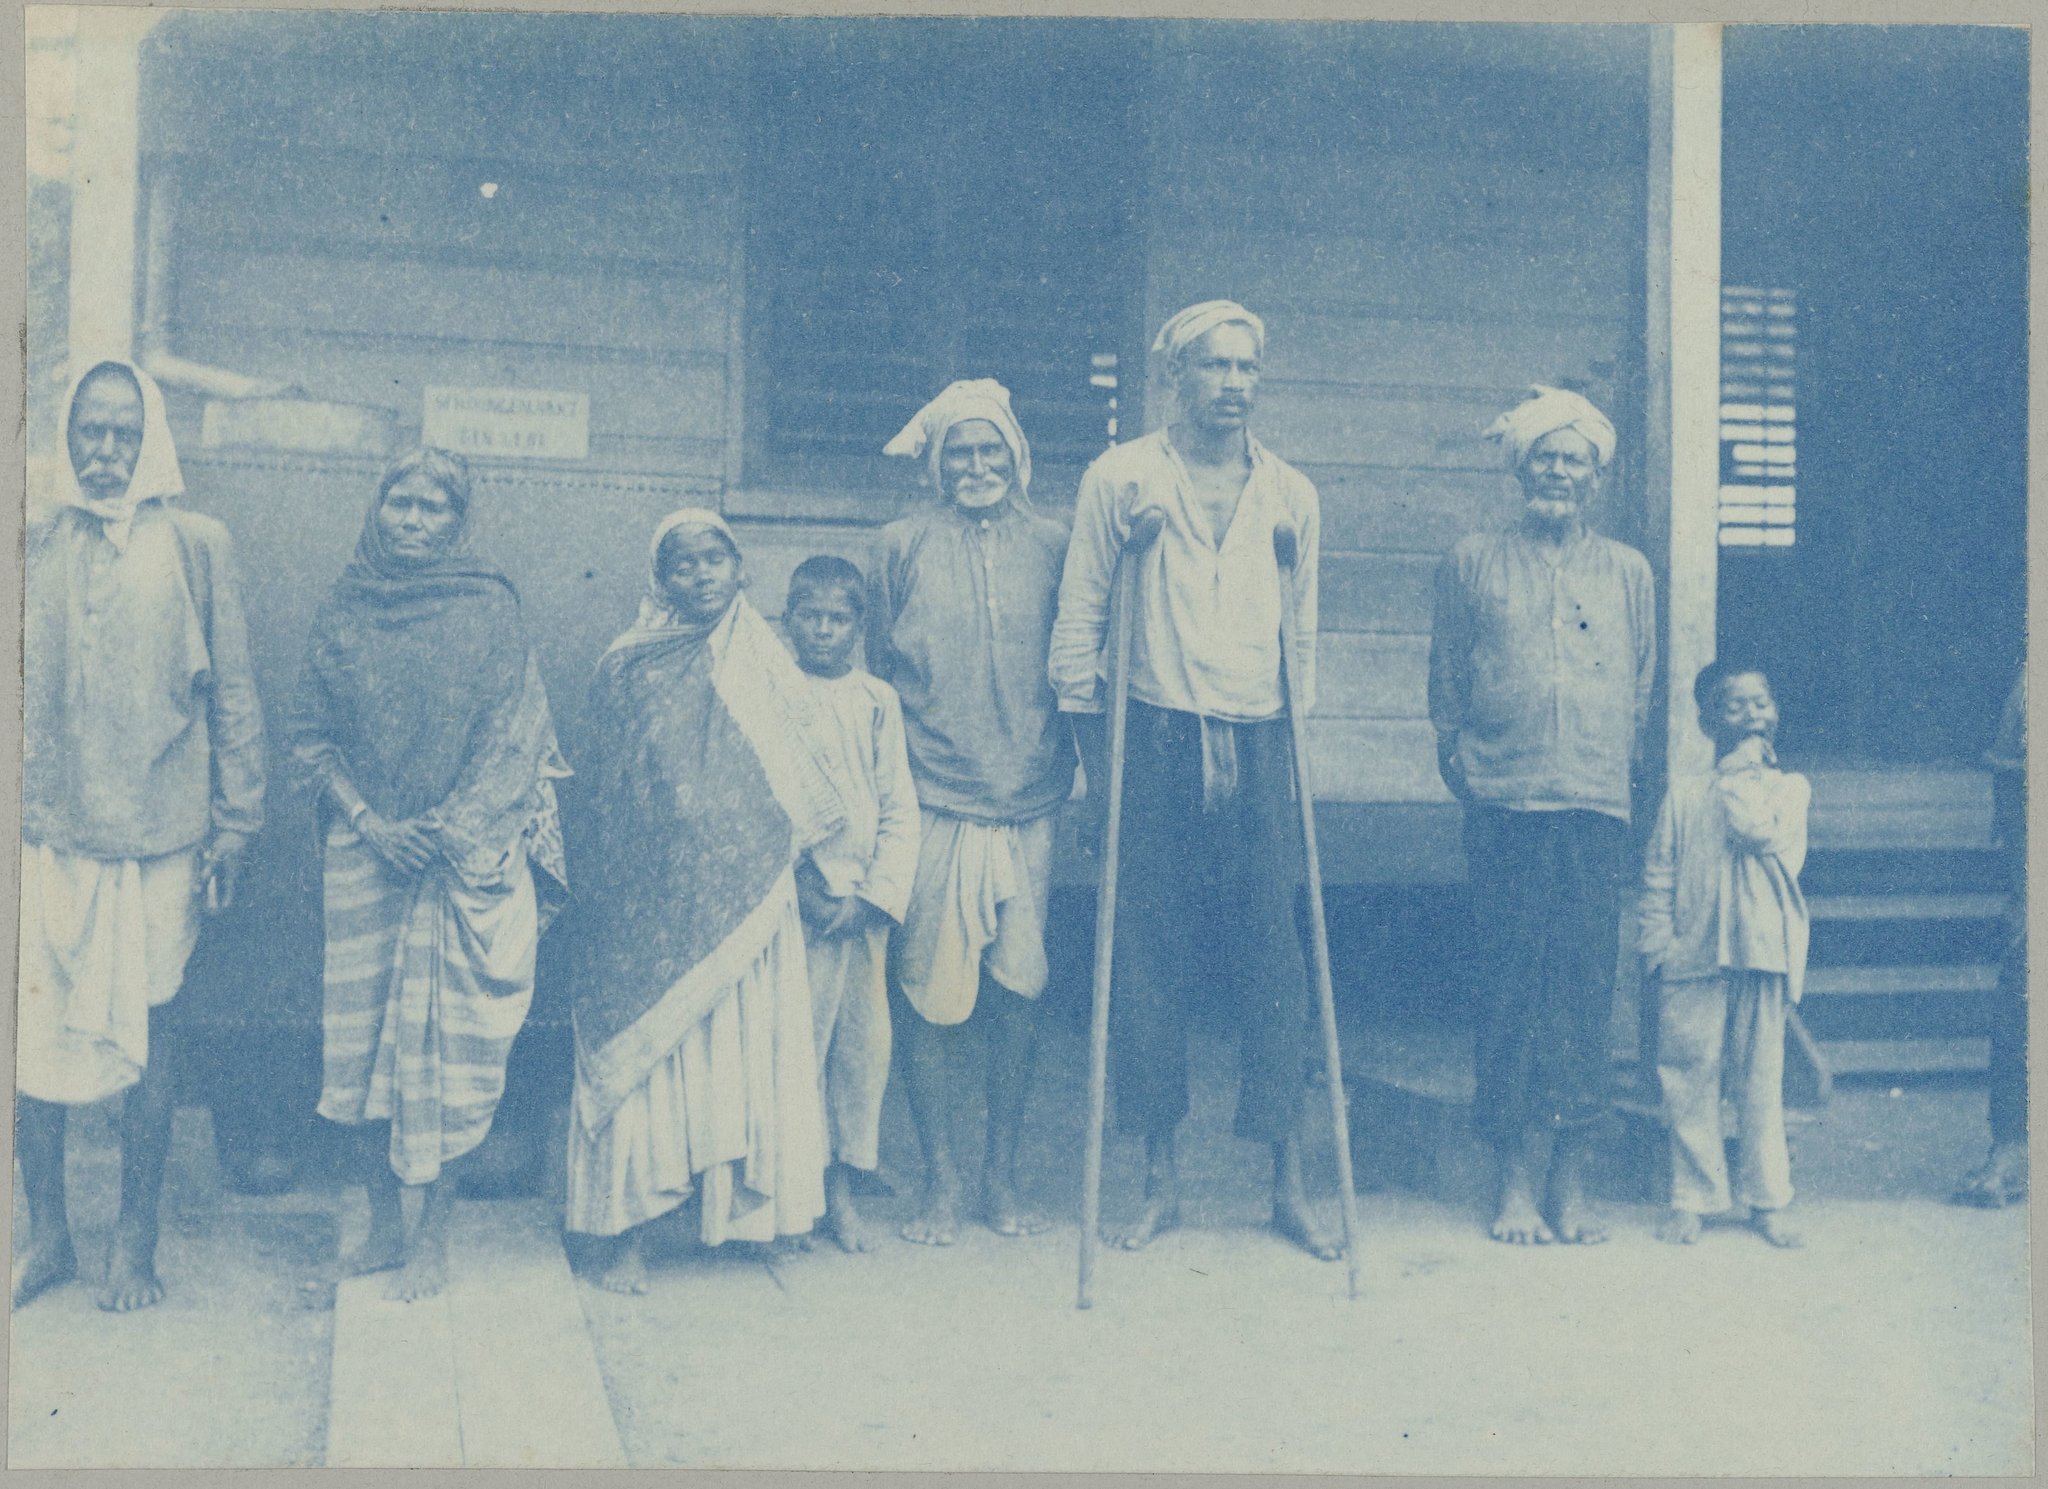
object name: photograph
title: Op 's Landsgrond Boniface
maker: hendrik doijer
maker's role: engineer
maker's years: 1863-1925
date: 1903-1910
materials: photographic support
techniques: cyanotype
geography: suriname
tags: suriname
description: Zes volwassenen en twee kinderen (Hindostanen) staande voor het bejaardenhuis of weldadigheidsgesticht 's-Landsgrond Boniface te Paramaribo. Onderdeel van het fotoalbum Souvenir de Voyage (deel 3), over het leven van de familie Doijer in en rond de plantage Ma Retraite in Suriname in de jaren 1903-1910.